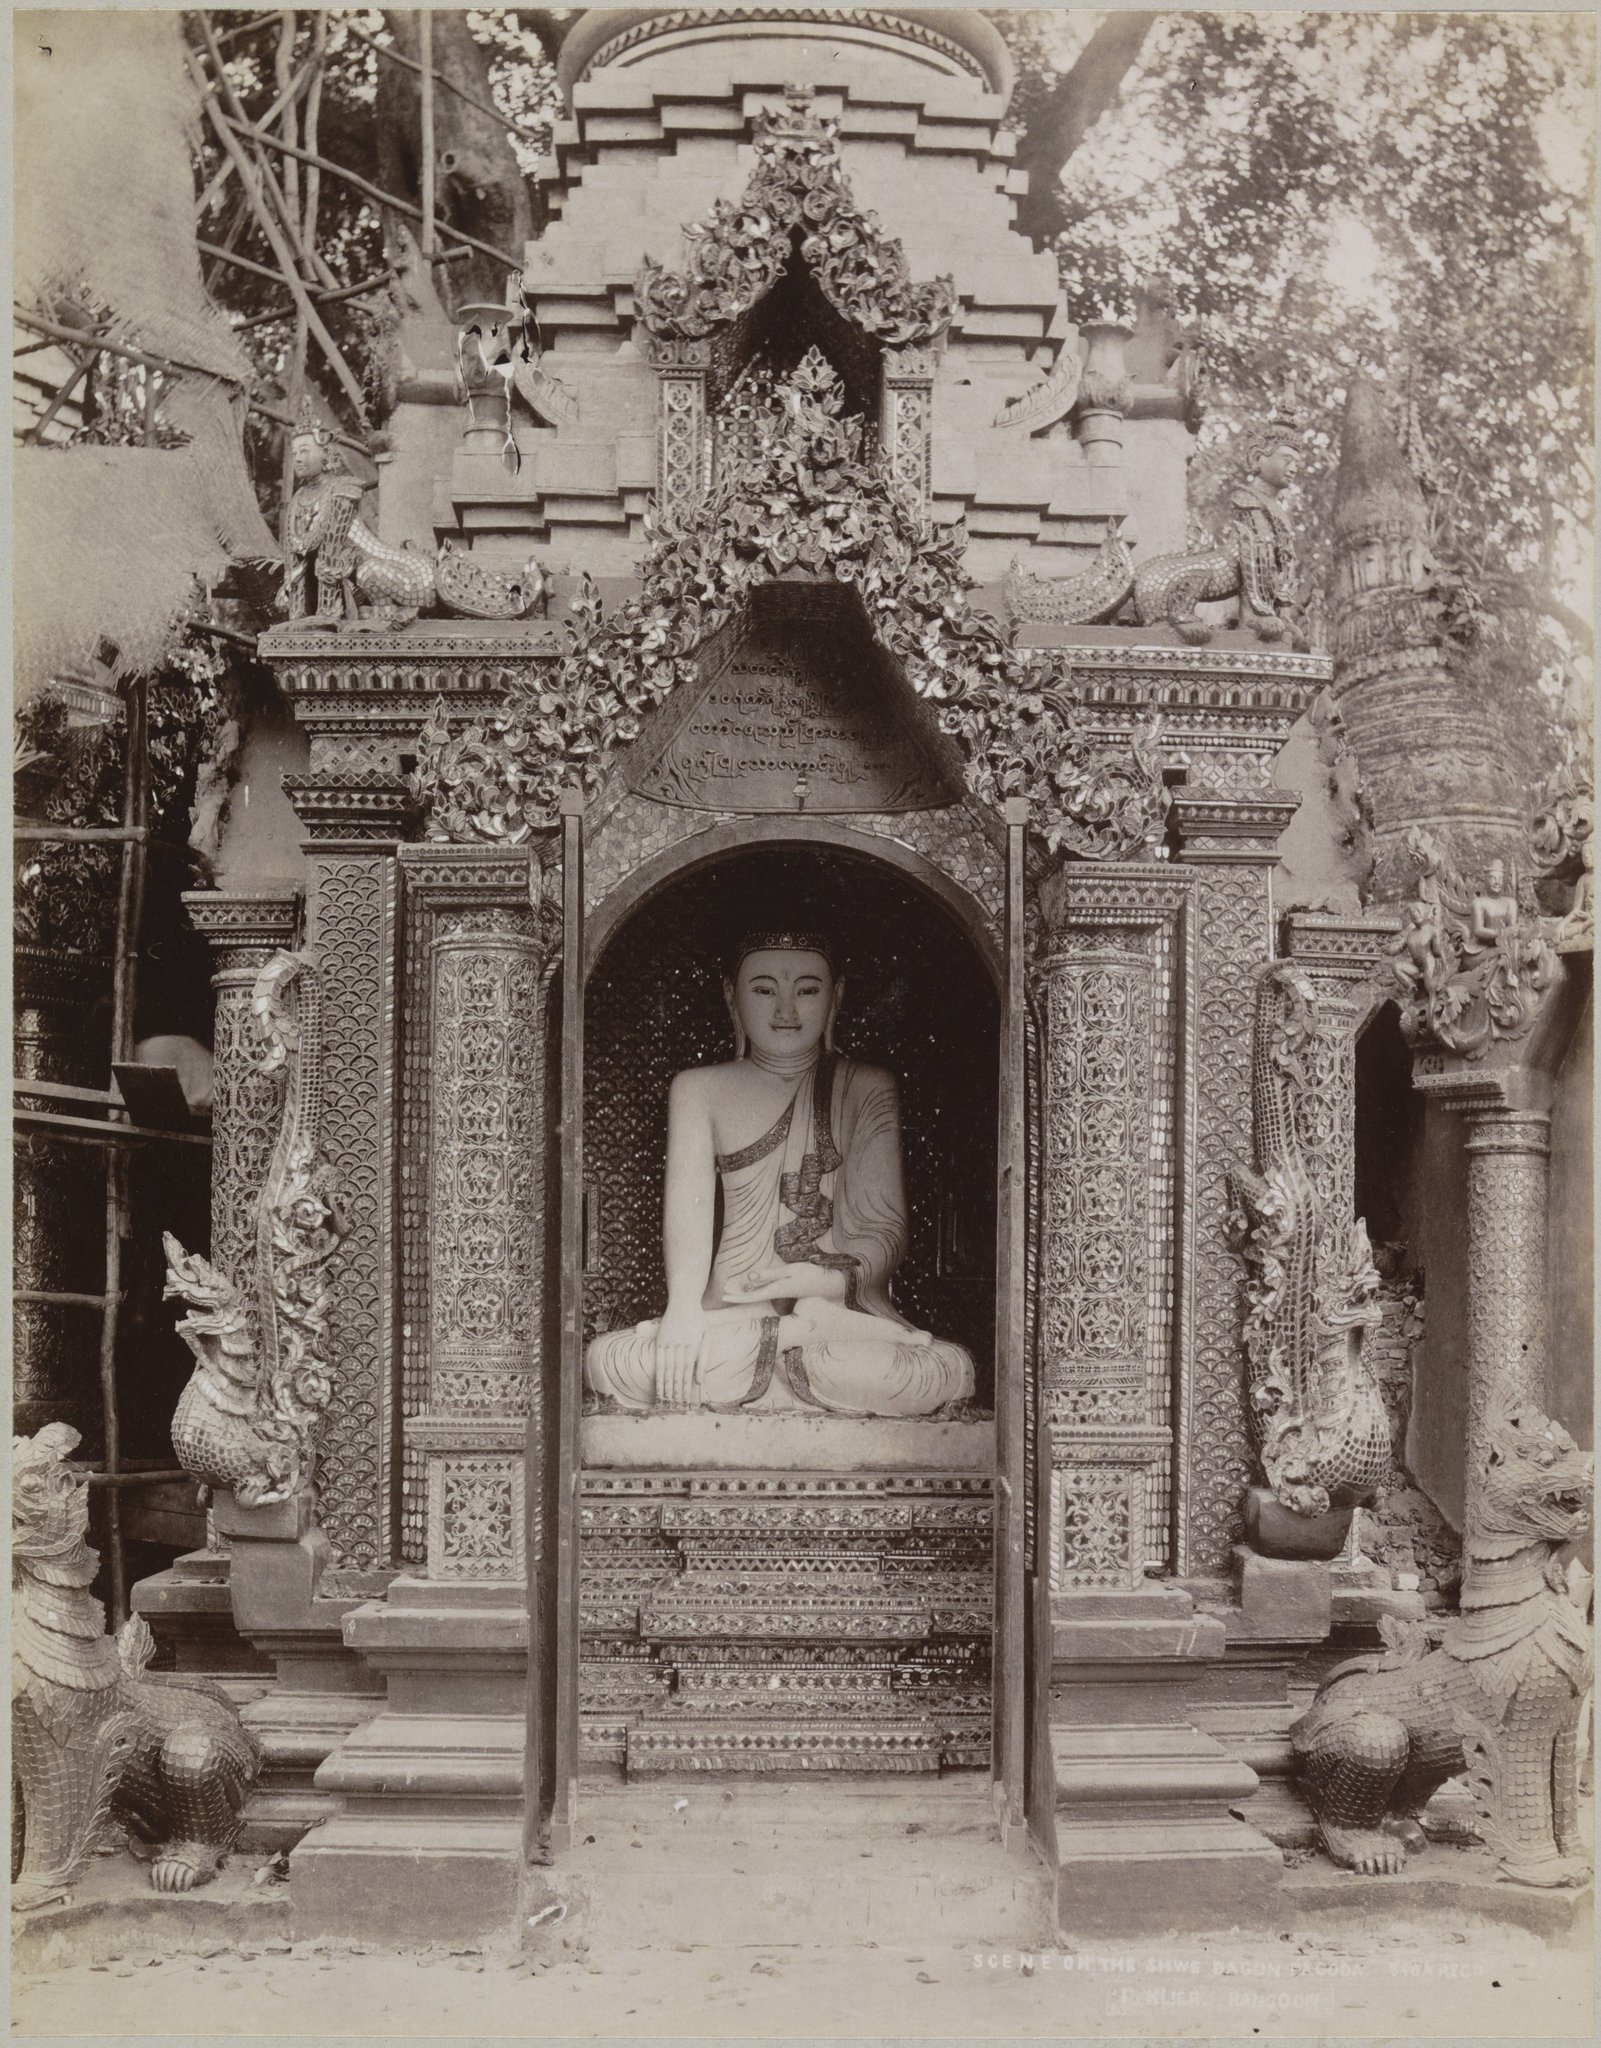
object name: photograph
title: Idol of Buddha in a niche at the Shwedagon pagoda, Yangon, Myanmar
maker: philip adolphe klier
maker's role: fotograaf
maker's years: 1845-1911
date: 1895-1915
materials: cardboard, paper, photographic support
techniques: albumen print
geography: yangon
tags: yangon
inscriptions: inscription: ‘Scene on the Shwe Dagon Pagoda. B46A Recd./ P. Klier. Rangoon.’, number: ‘6.’